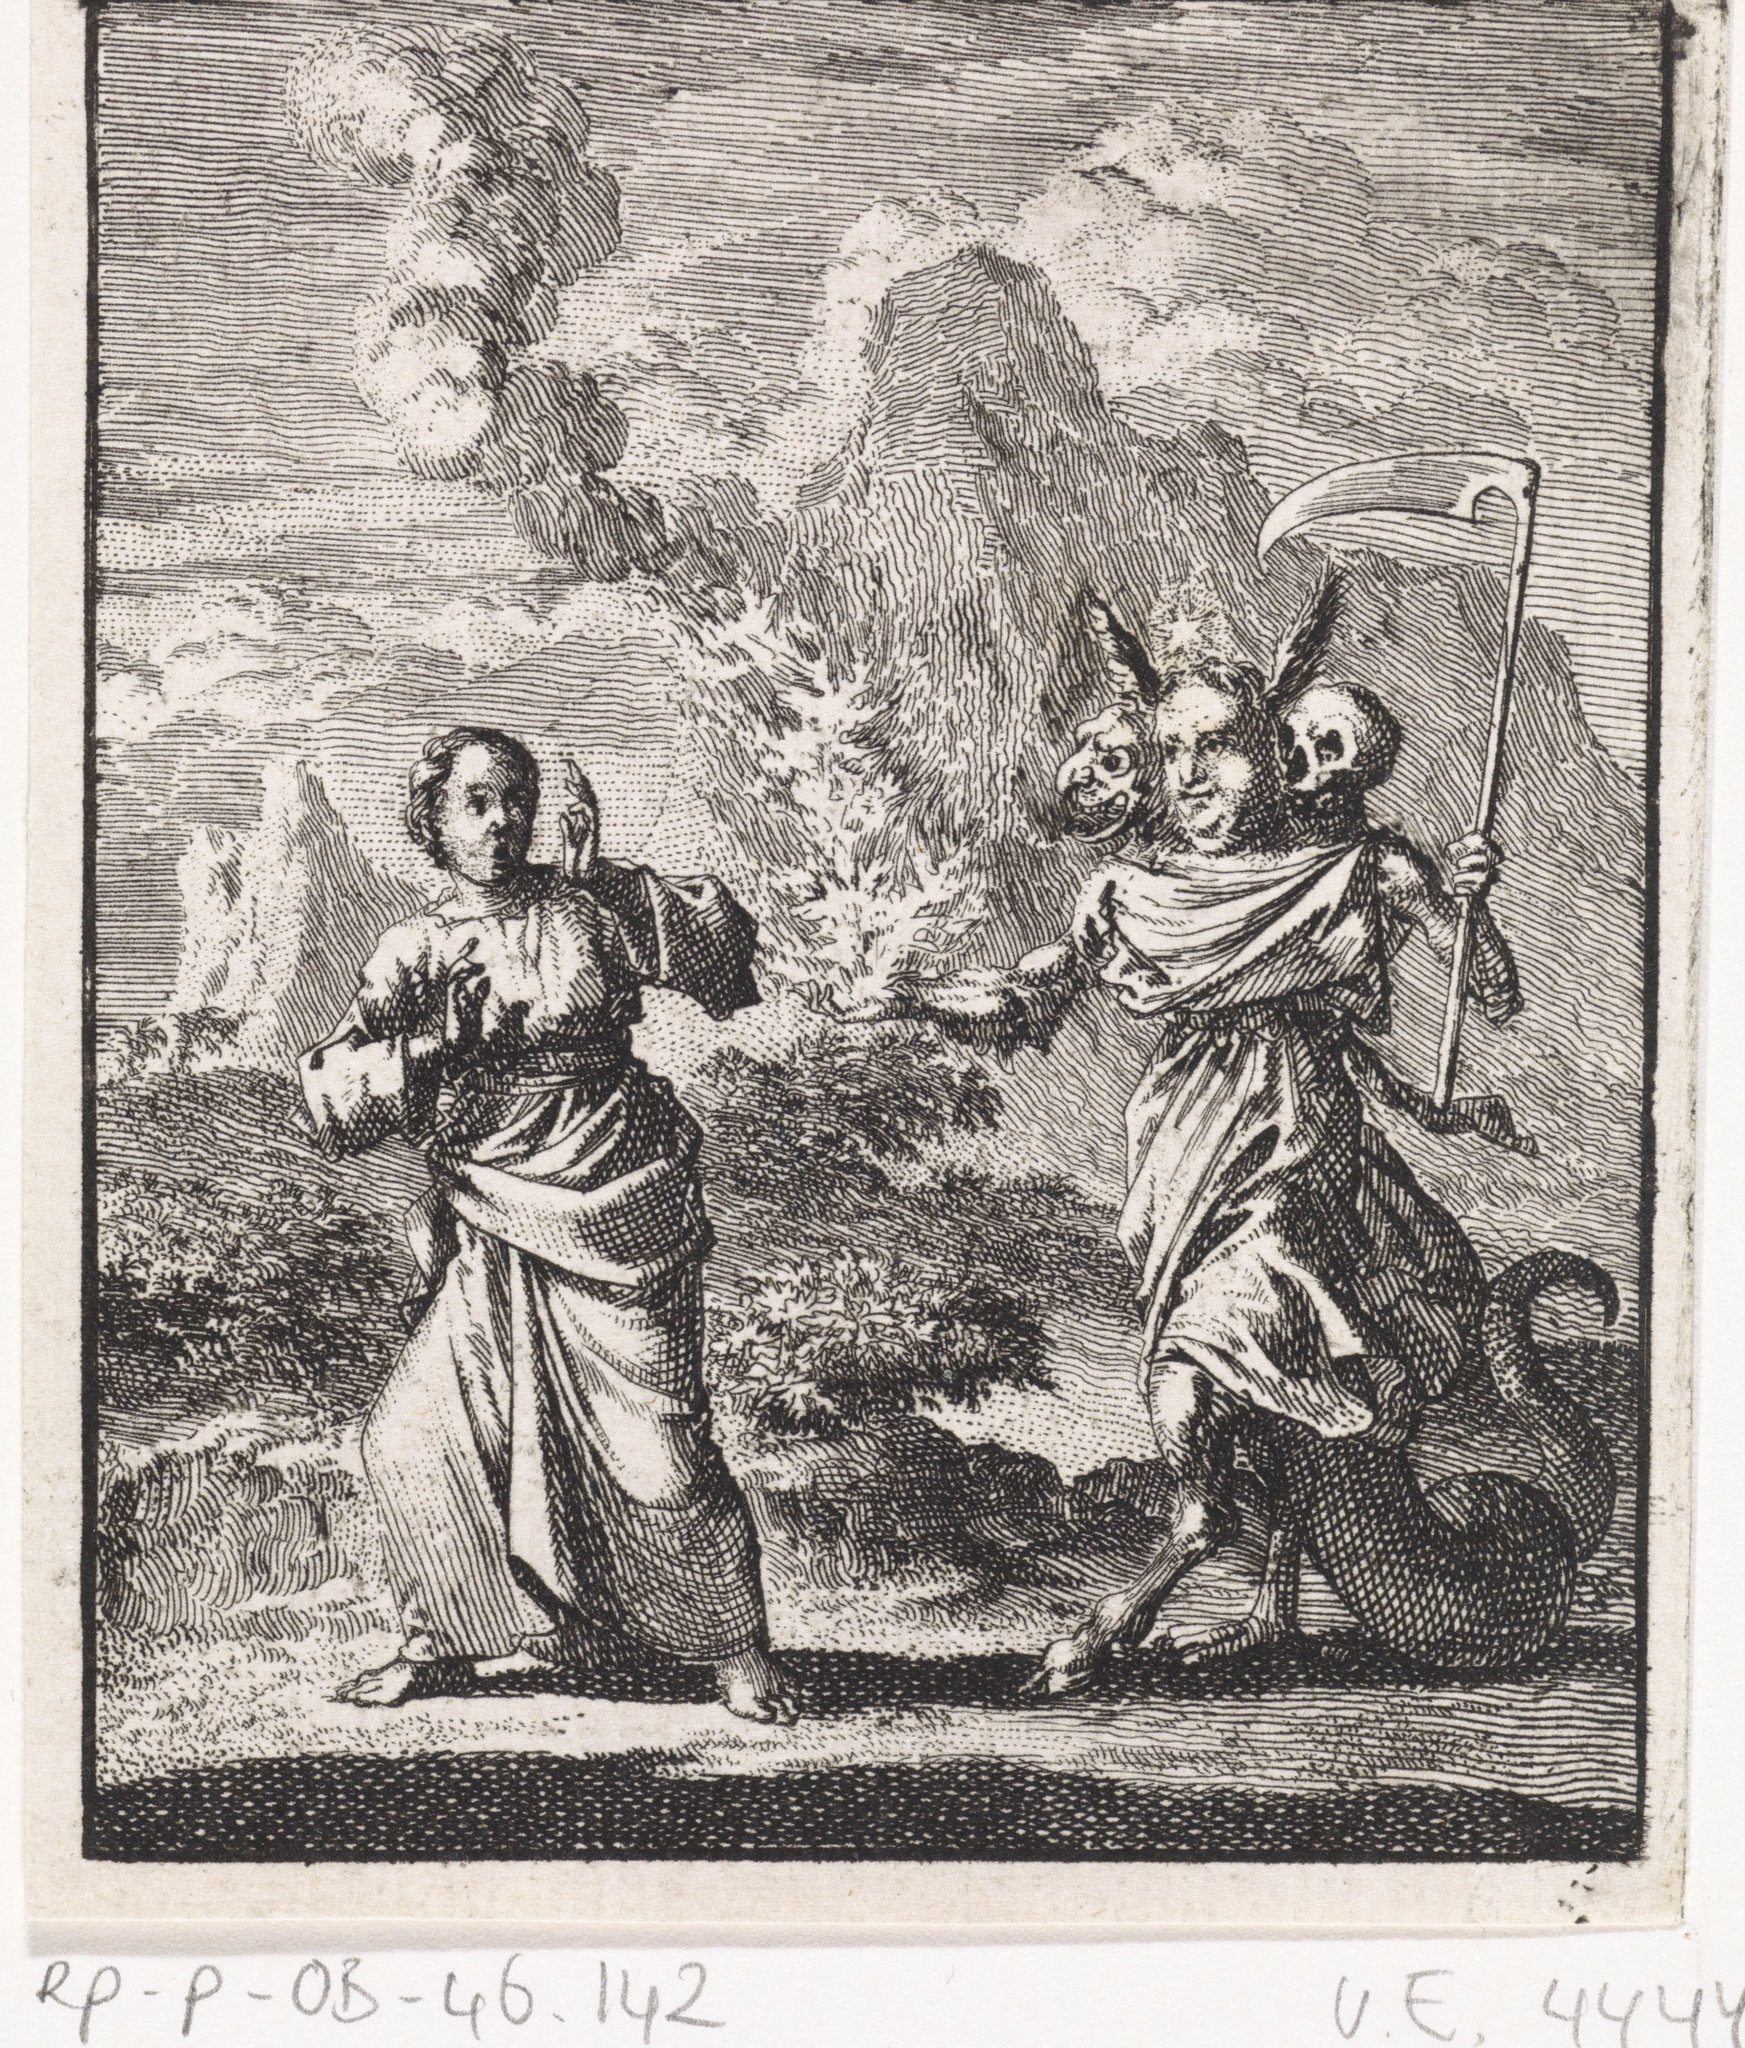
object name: print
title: De Ziel ontmoet de Zonde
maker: jan luyken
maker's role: draughtsman, print maker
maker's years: 1649-1712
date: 1714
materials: paper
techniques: etching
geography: amsterdam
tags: vice, evil, sin; 'peccato' (ripa), the soul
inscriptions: collector's mark: Lugt 2228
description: Proefdruk van illustratie uit: Luyken, Jan. Jezus en de Ziel, 3 delen. Amsterdam: Wed. Pieter Arentsz II en Cornelis van der Sys, 1714, dl. I, p. 23.